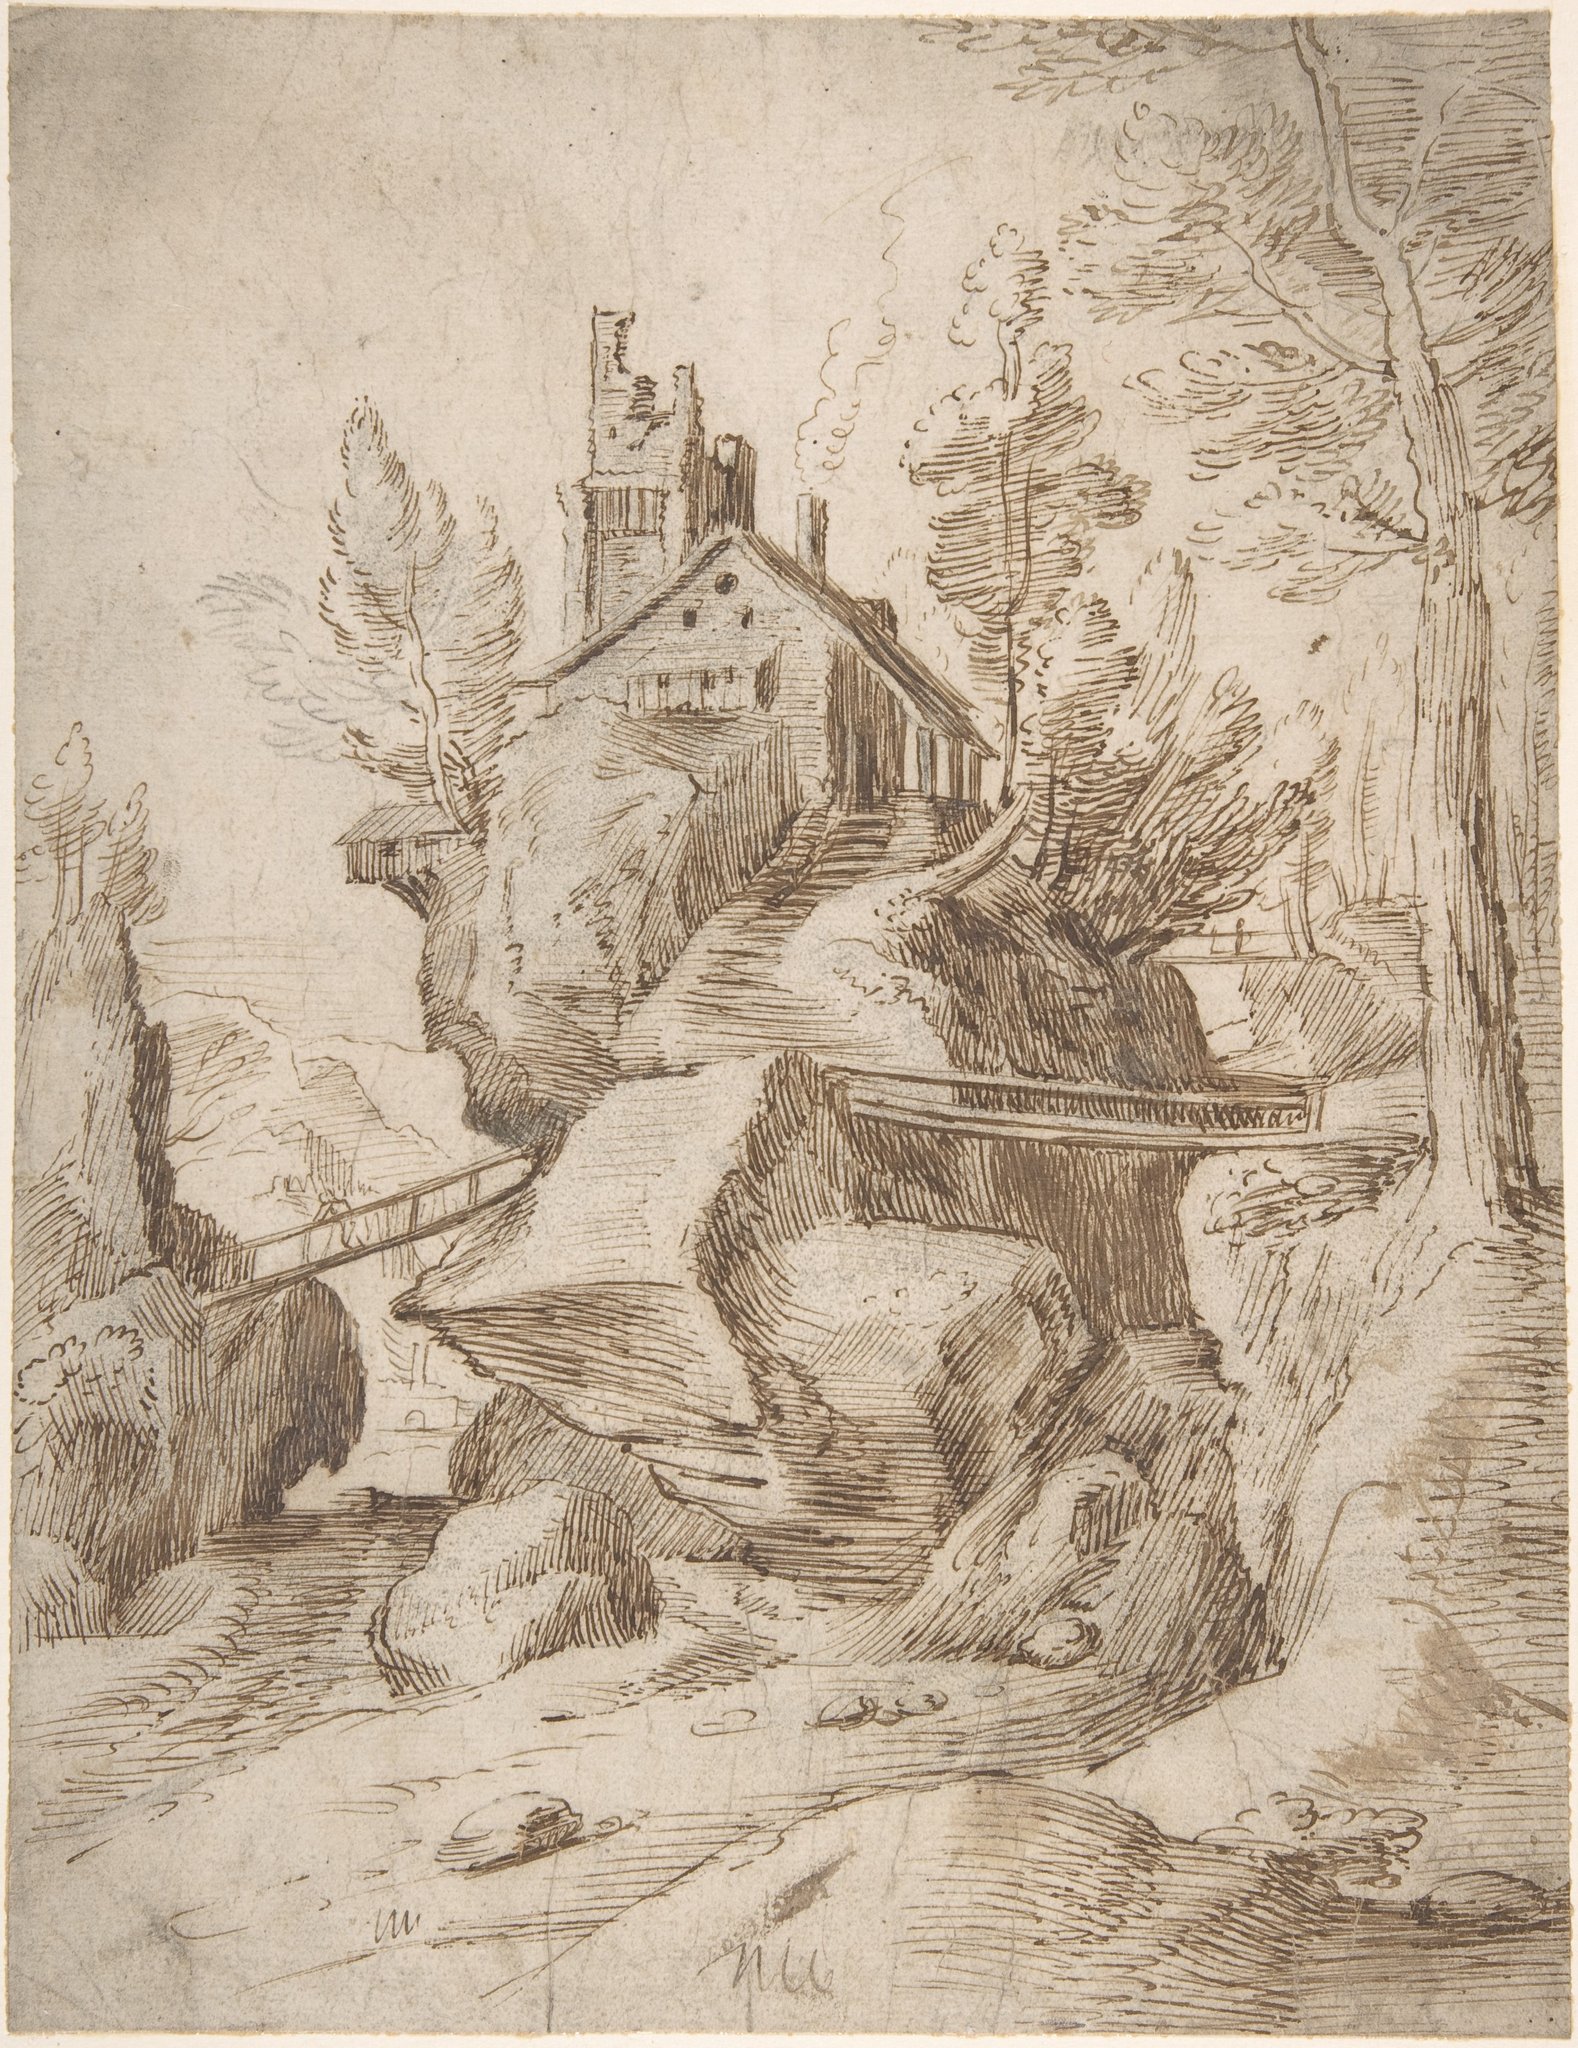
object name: drawing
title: Fantastic Rocky Landscape with a Farmhouse and Three Foot Bridges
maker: anonymous, netherlandish, 16th century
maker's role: artist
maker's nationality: netherlandish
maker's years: 1500-1600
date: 1570-1583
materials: chalk, ink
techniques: pen, wash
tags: houses,bridges,landscapes,trees